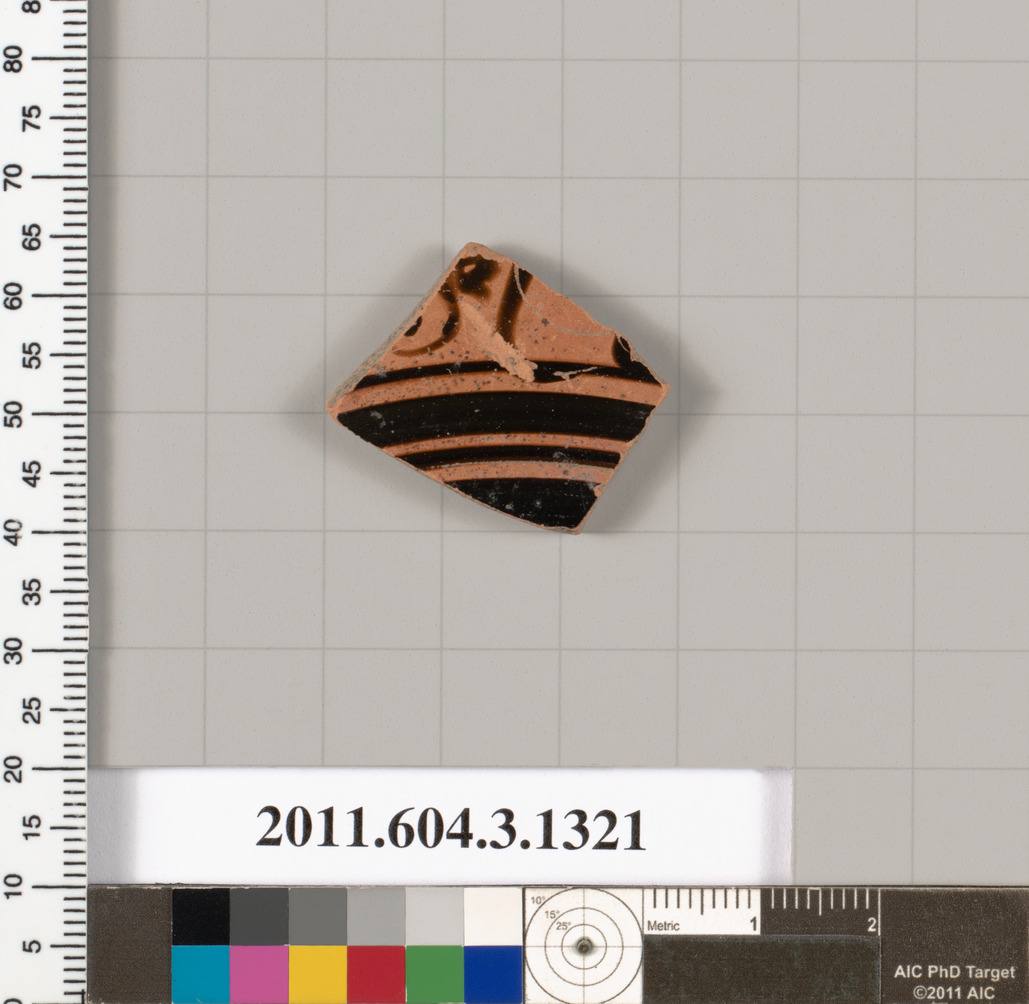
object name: skyphos fragment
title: Terracotta fragment of a skyphos (deep drinking cup)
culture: greek, attic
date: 490-480 BCE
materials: terracotta